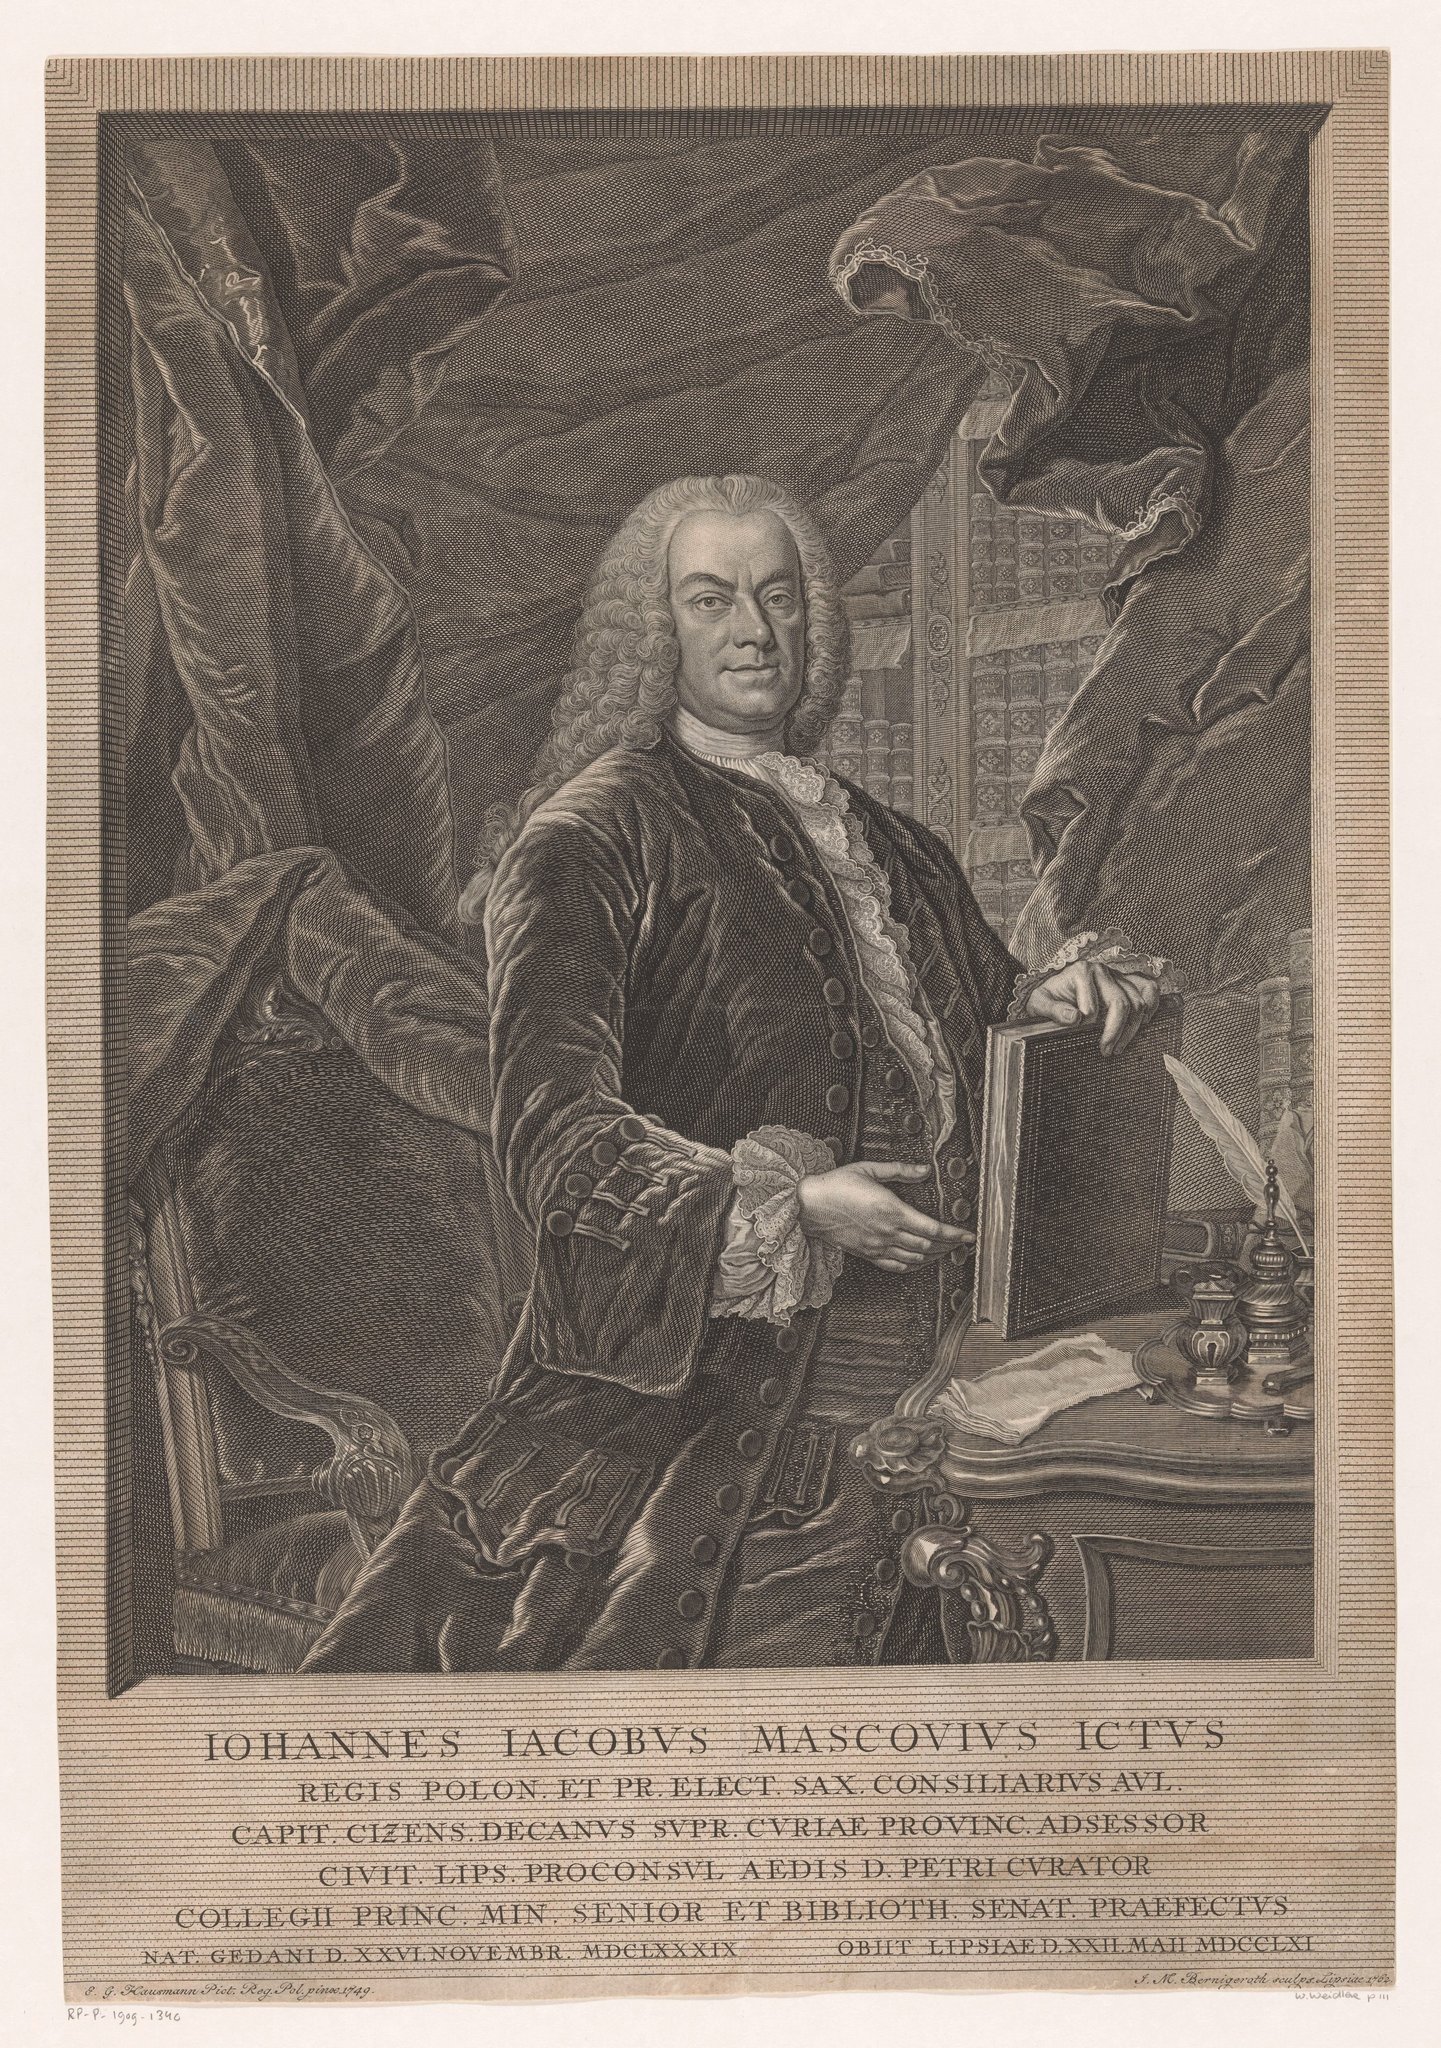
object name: print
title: Portret van Johann Jakob Mascov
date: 1762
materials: paper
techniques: engraving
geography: leipzig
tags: bookshelves, ink-well, historical persons, book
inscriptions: collector's mark: Lugt 2228